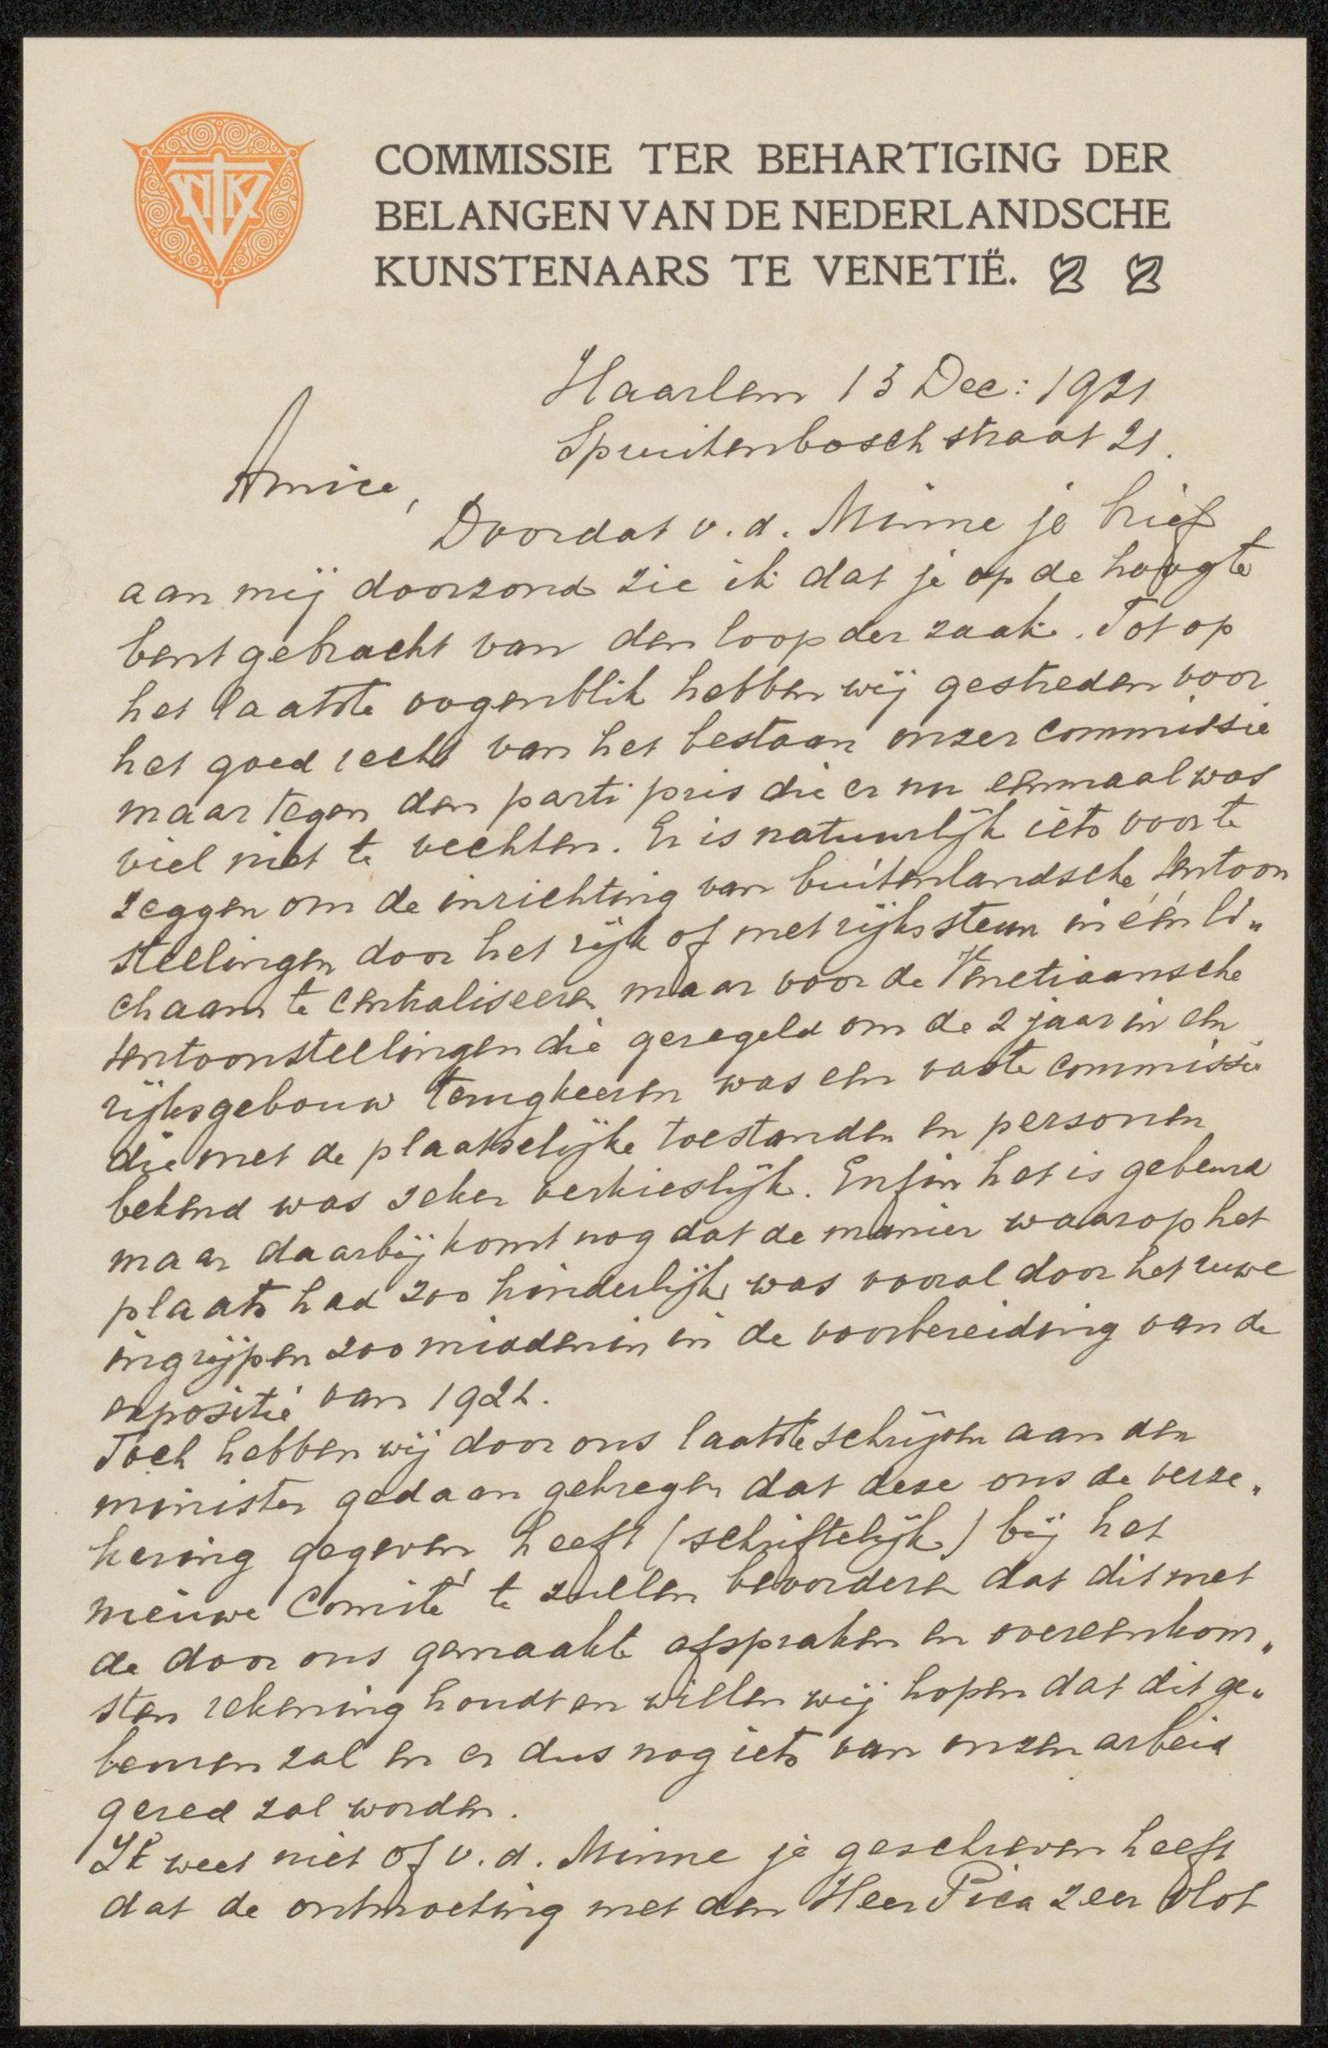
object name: letter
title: Brief aan Philip Zilcken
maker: anton l. koster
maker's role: draughtsman, painter, print maker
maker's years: 1859-1937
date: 1921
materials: ink, paper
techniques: pen, printing, writing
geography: haarlem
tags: willem maris, naples, vittorio pica, ernst van der minne, paris, mozes isaac duparc, the hague, painter, draughtsman, philip zilcken, art trade, art shop, painting (including book-illumination, miniature-painting), exhibition ~ art, artist at work, in his workshop - bb - out of doors, venice